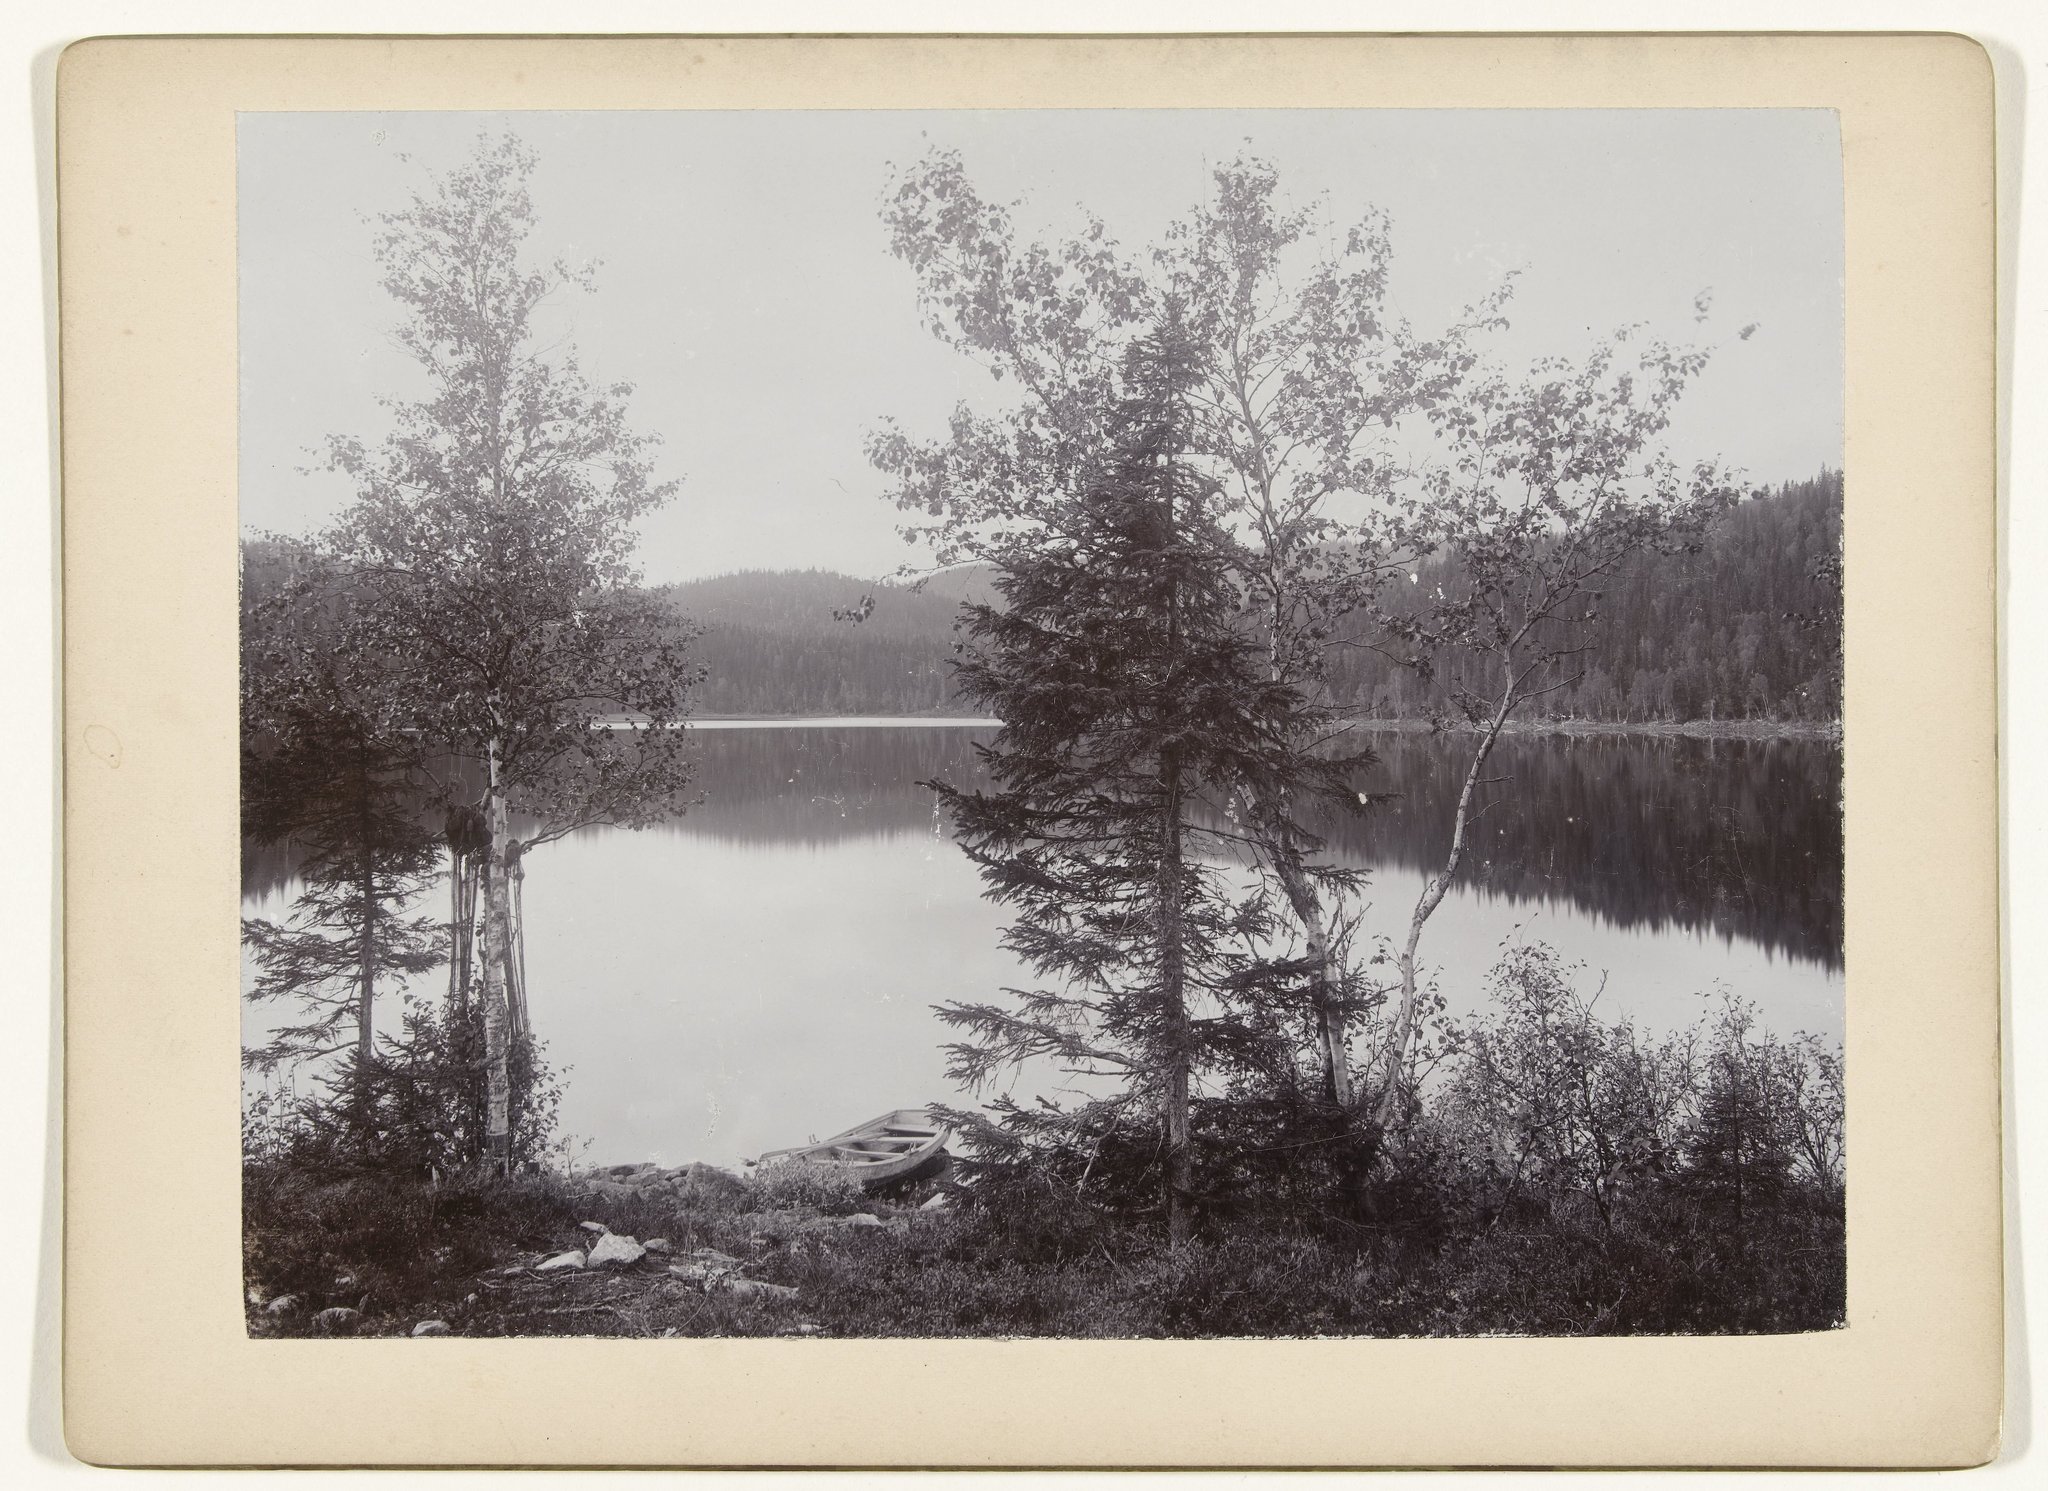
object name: photograph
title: Bomen aan een meer (Noorwegen?)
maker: henry pauw van wieldrecht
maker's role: fotograaf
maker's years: 1863-1912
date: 1899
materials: cardboard, photographic support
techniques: gelatin silver print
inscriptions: annotation: ‘No 1662. - 1899.’